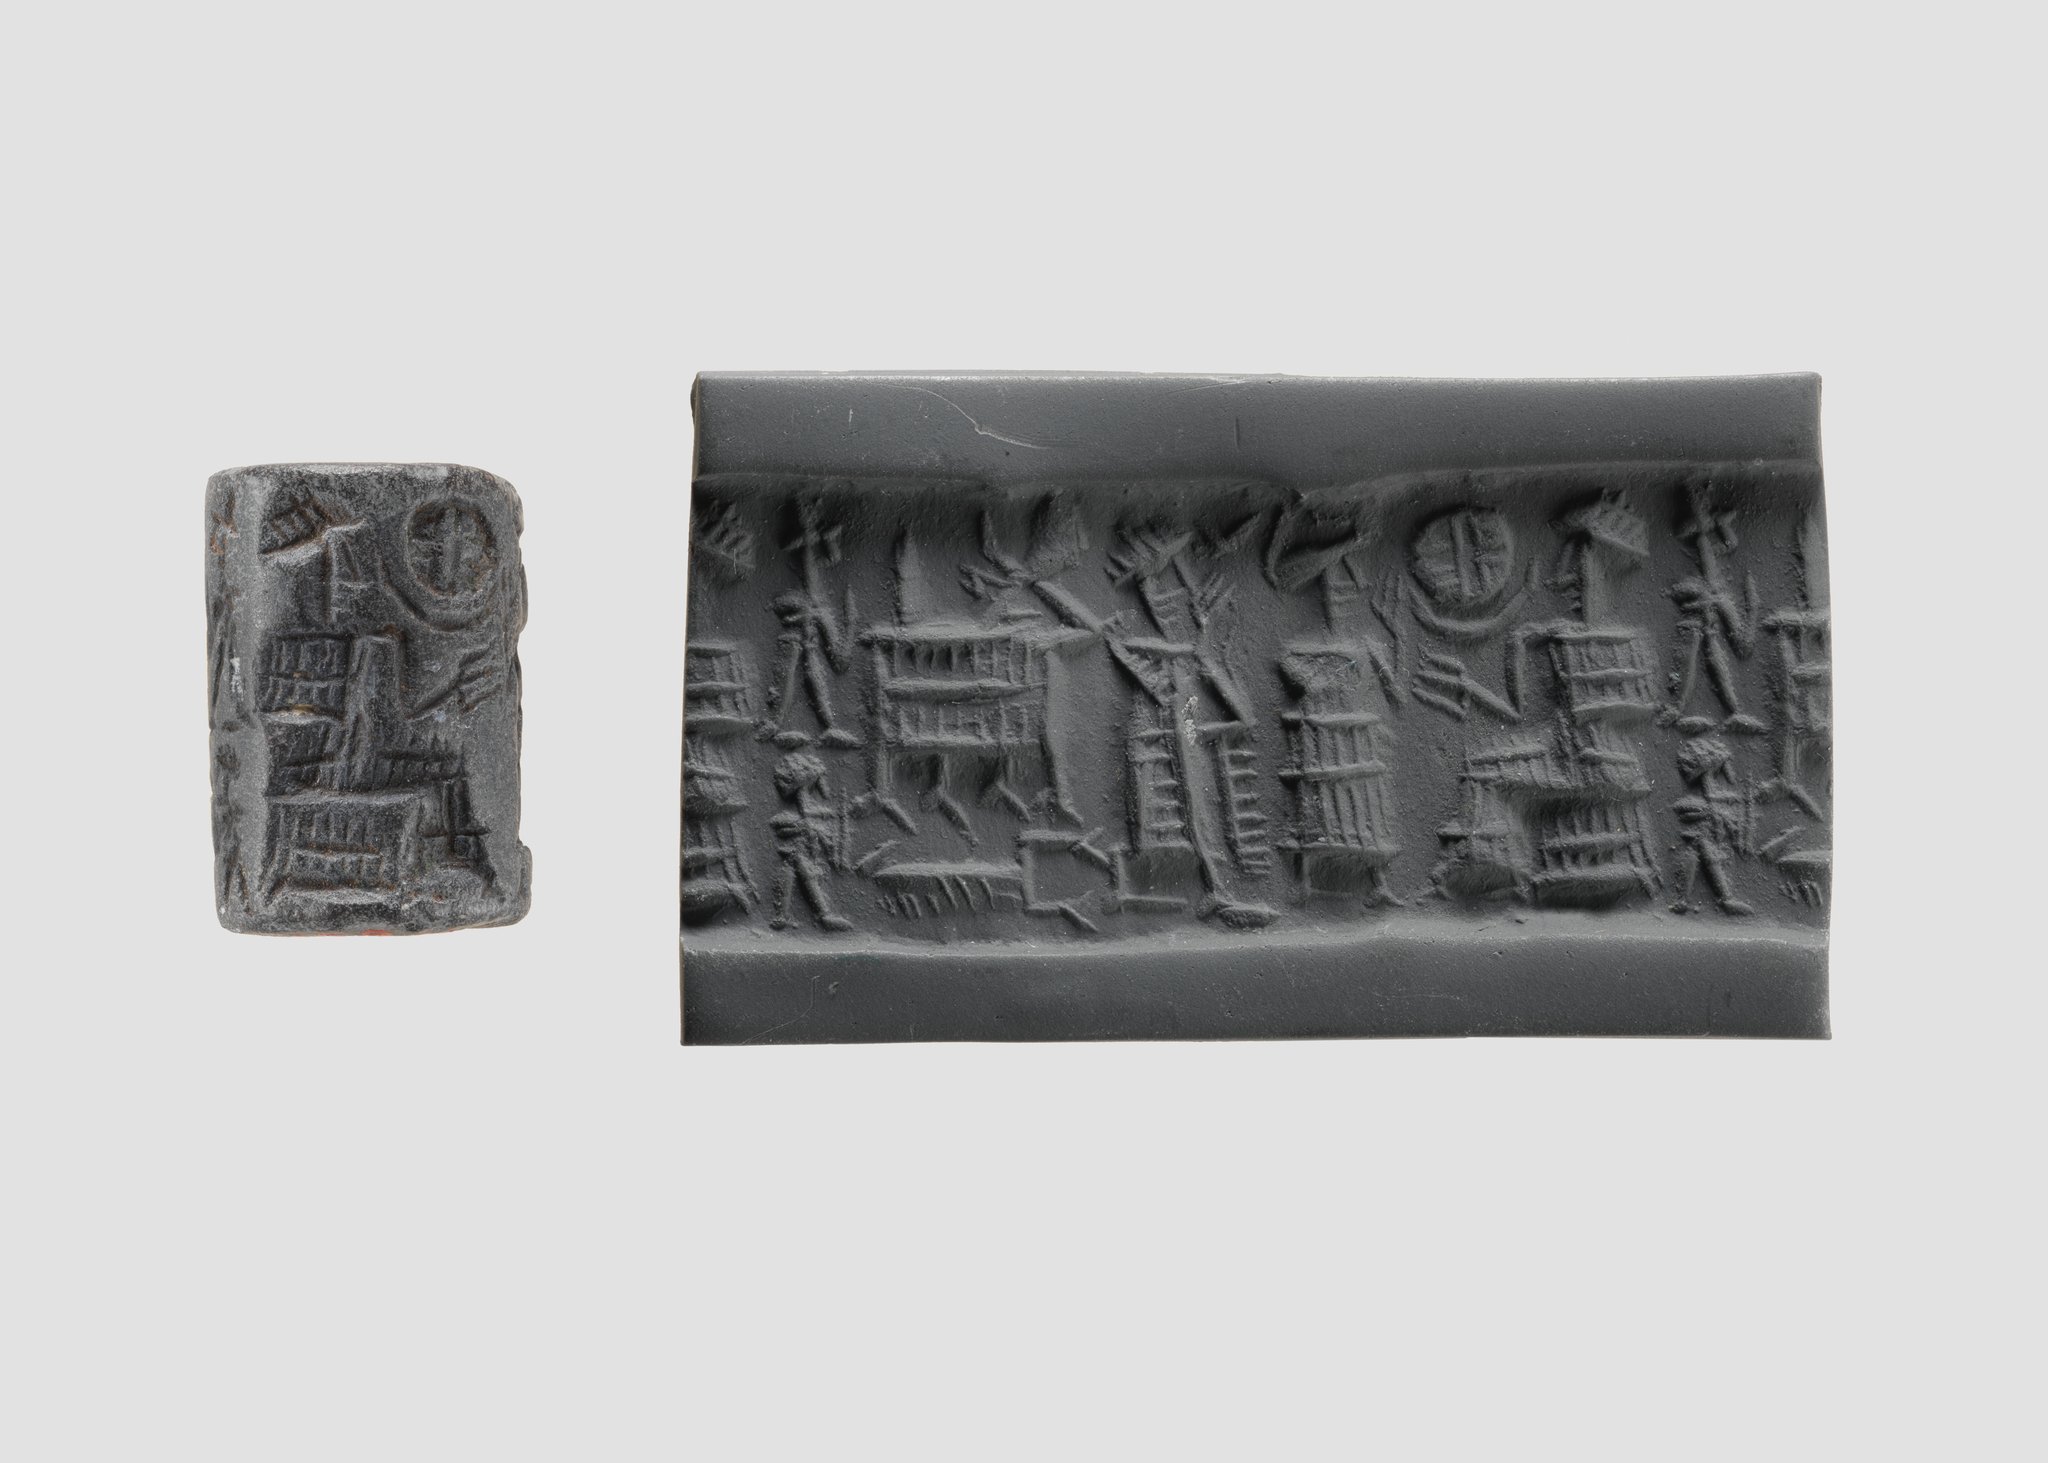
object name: cylinder seal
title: Cylinder seal and modern impression: seated figure approached by a goddess leading a worshiper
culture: assyrian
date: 2000-1668 BCE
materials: mineral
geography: anatolia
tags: goddess